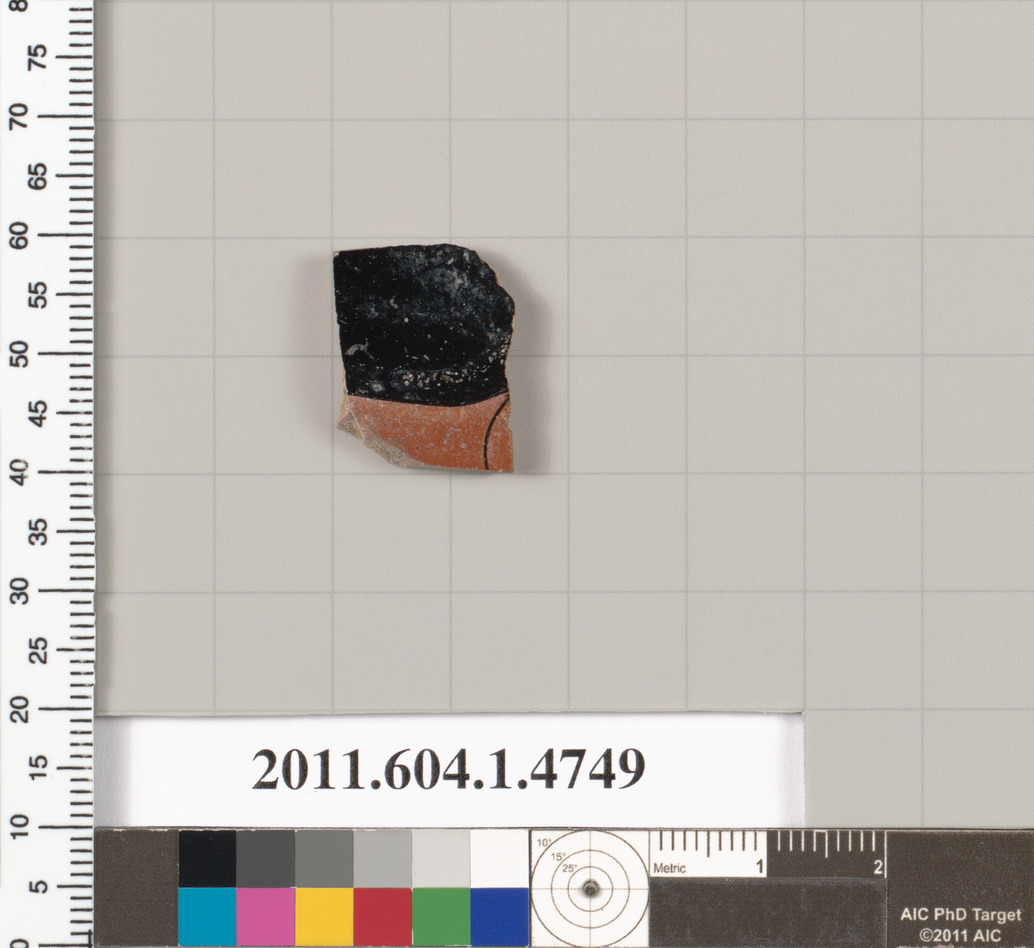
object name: kylix fragment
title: Terracotta fragment of a kylix (drinking cup)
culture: greek, attic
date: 490-470 BCE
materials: terracotta